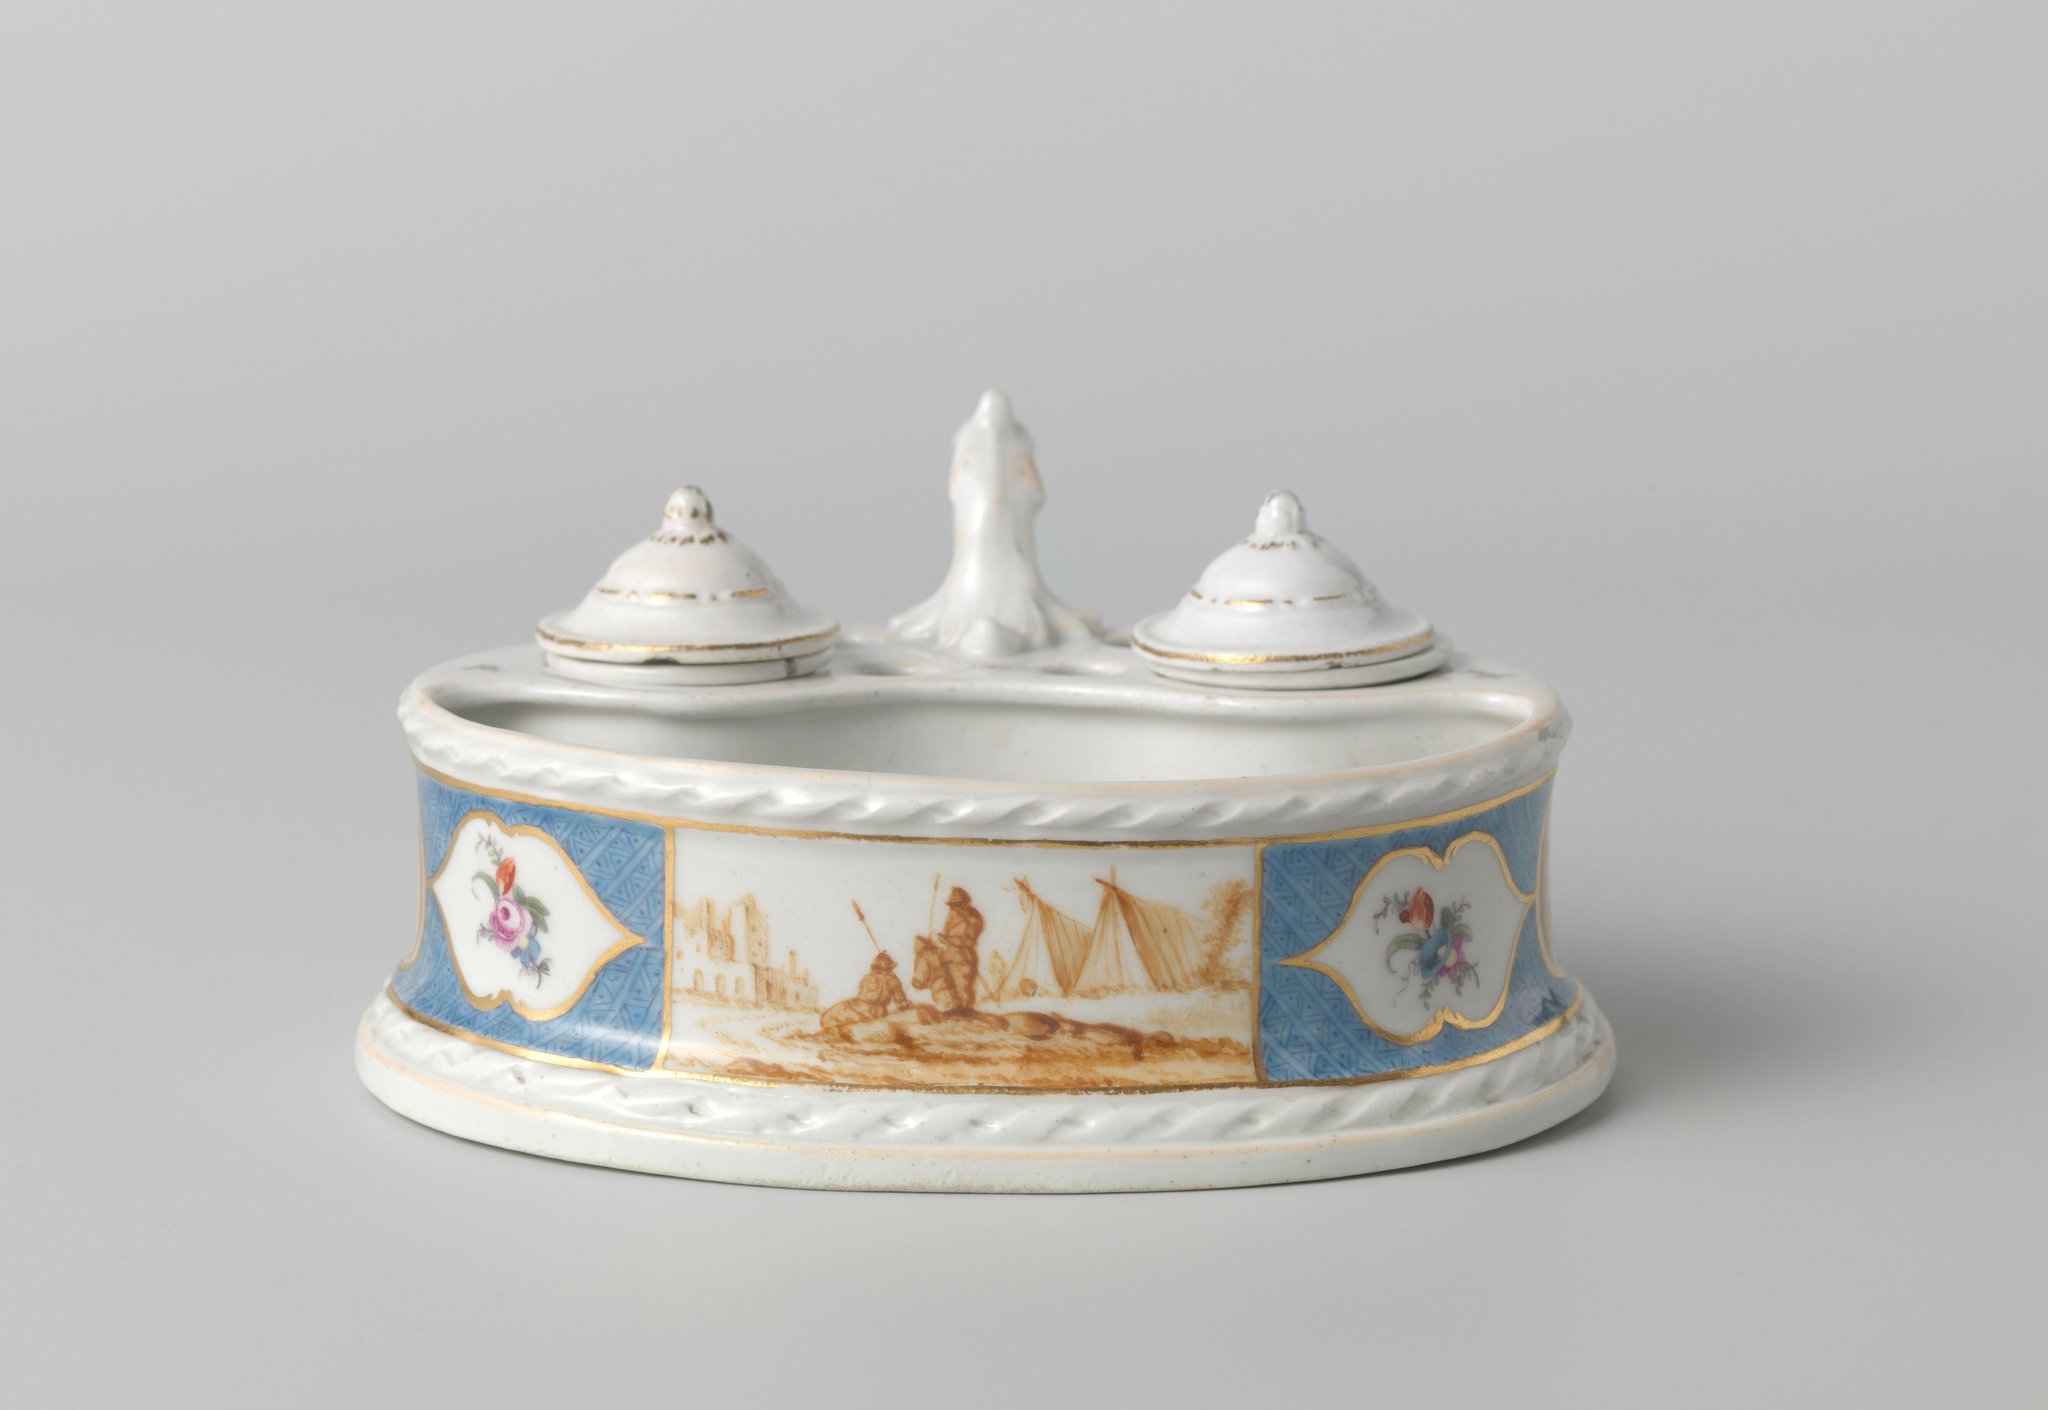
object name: inkstand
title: Deksel van zandstrooier of inktpot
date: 1778-1782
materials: porcelain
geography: loosdrecht